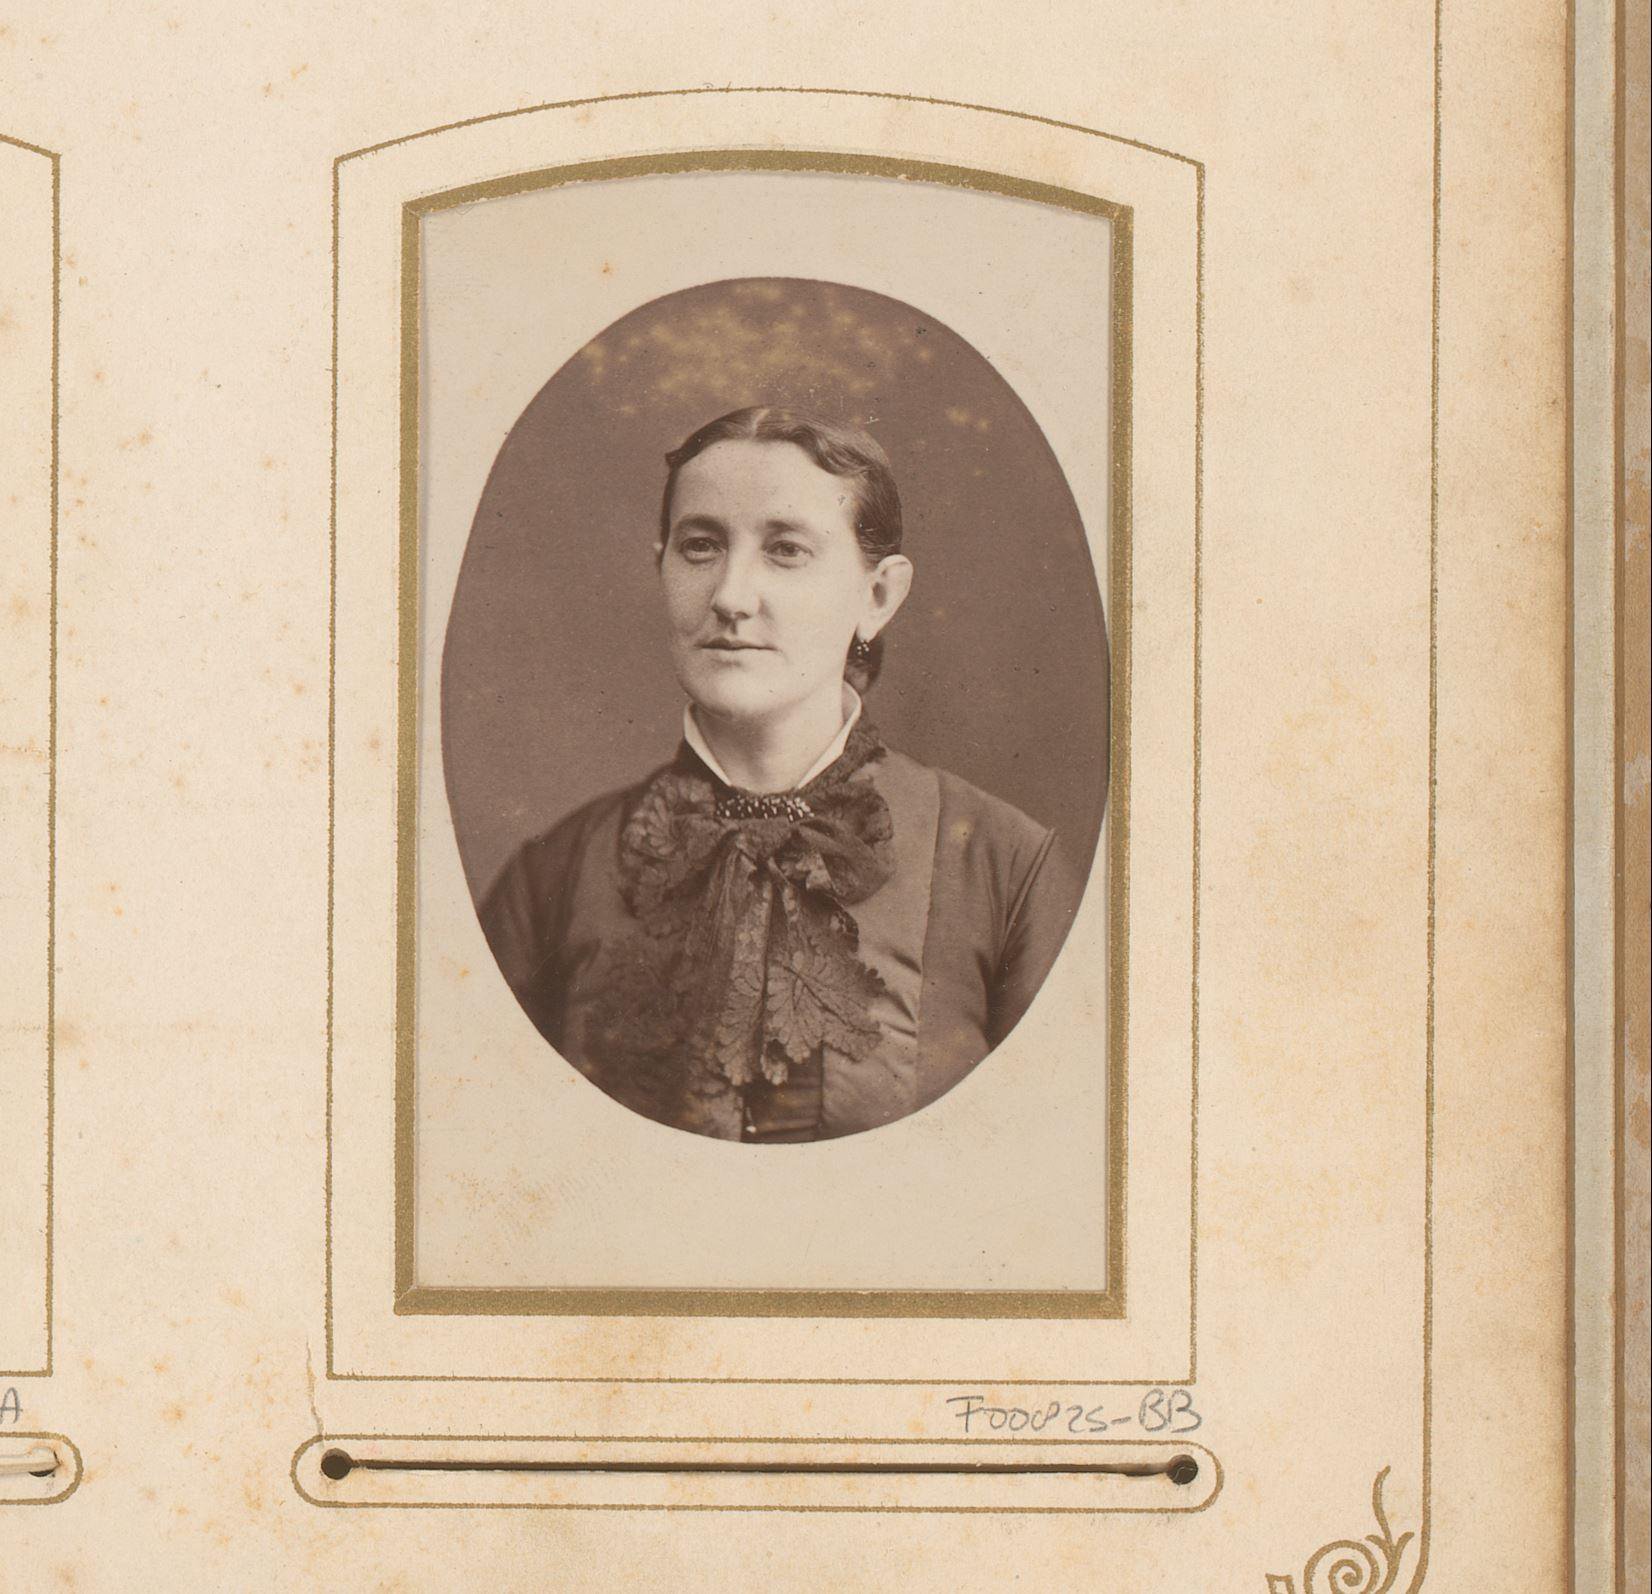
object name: photograph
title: Portret van een vrouw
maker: jacques chits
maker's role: fotograaf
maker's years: 1835-1917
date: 1881-1887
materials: cardboard, photographic support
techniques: albumen print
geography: haarlem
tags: historical persons - bb - woman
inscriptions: inscription: ‘Photografische Inrigting JACQUES CHITS/ Waaigat No 14, by de Kruisstraat HAARLEM/ De plaat blijft ter nabestelling bewaard’